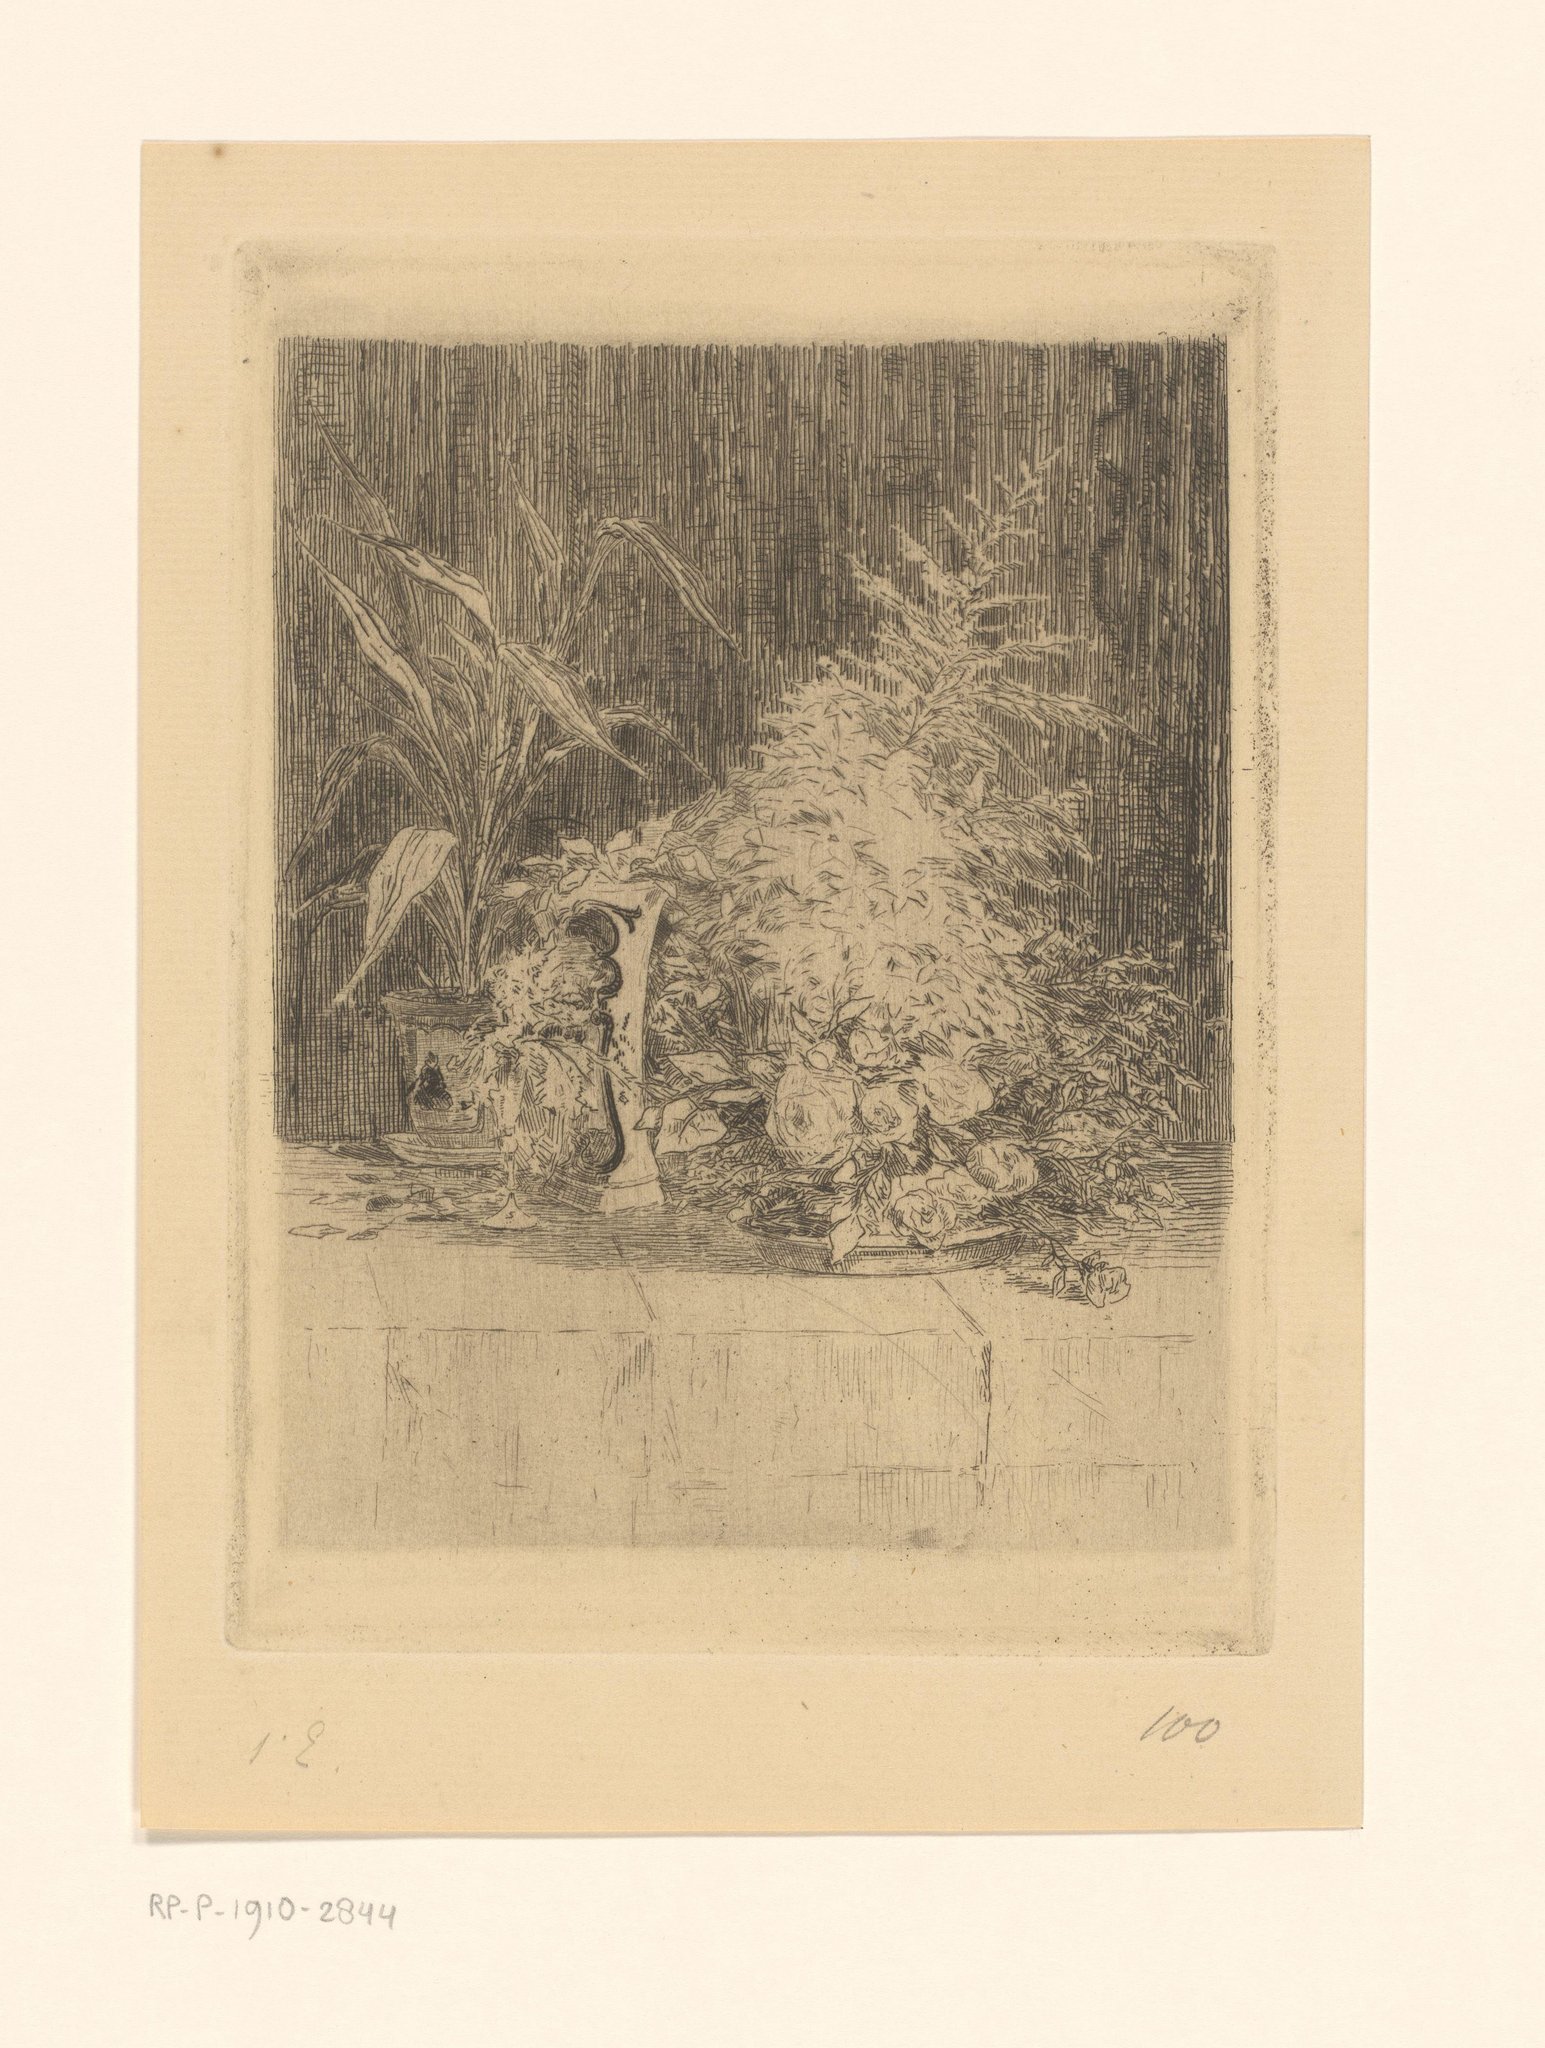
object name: print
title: Bloemstilleven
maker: carel nicolaas storm van s-gravesande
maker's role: draughtsman, print maker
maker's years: 1841-1924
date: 1851-1910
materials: paper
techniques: etching, intaglio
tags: still life of plants, flowers and fruit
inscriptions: collector's mark: Lugt 2228